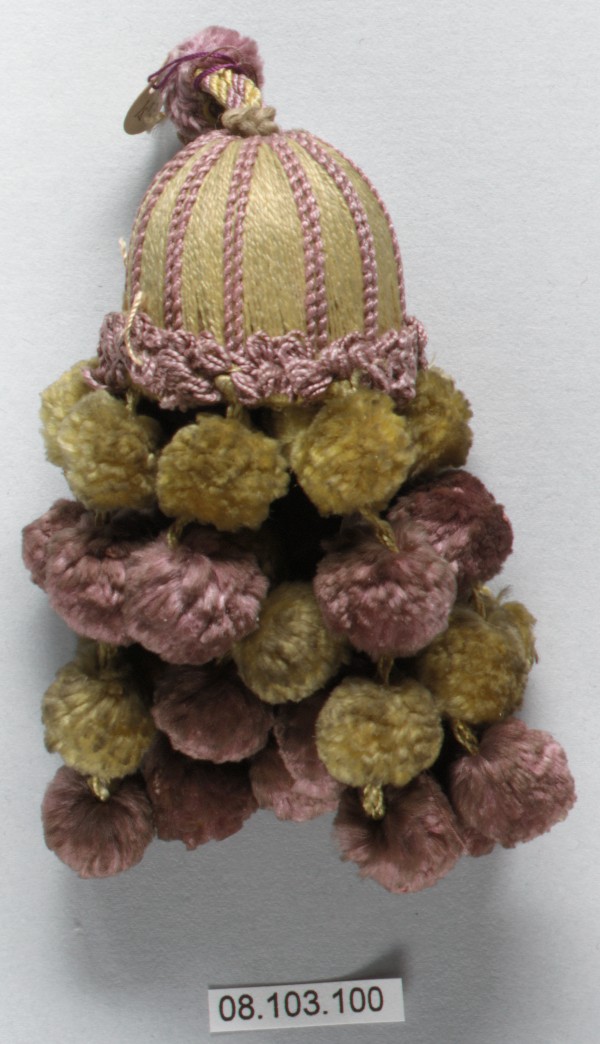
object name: tassel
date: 1801-1900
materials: silk